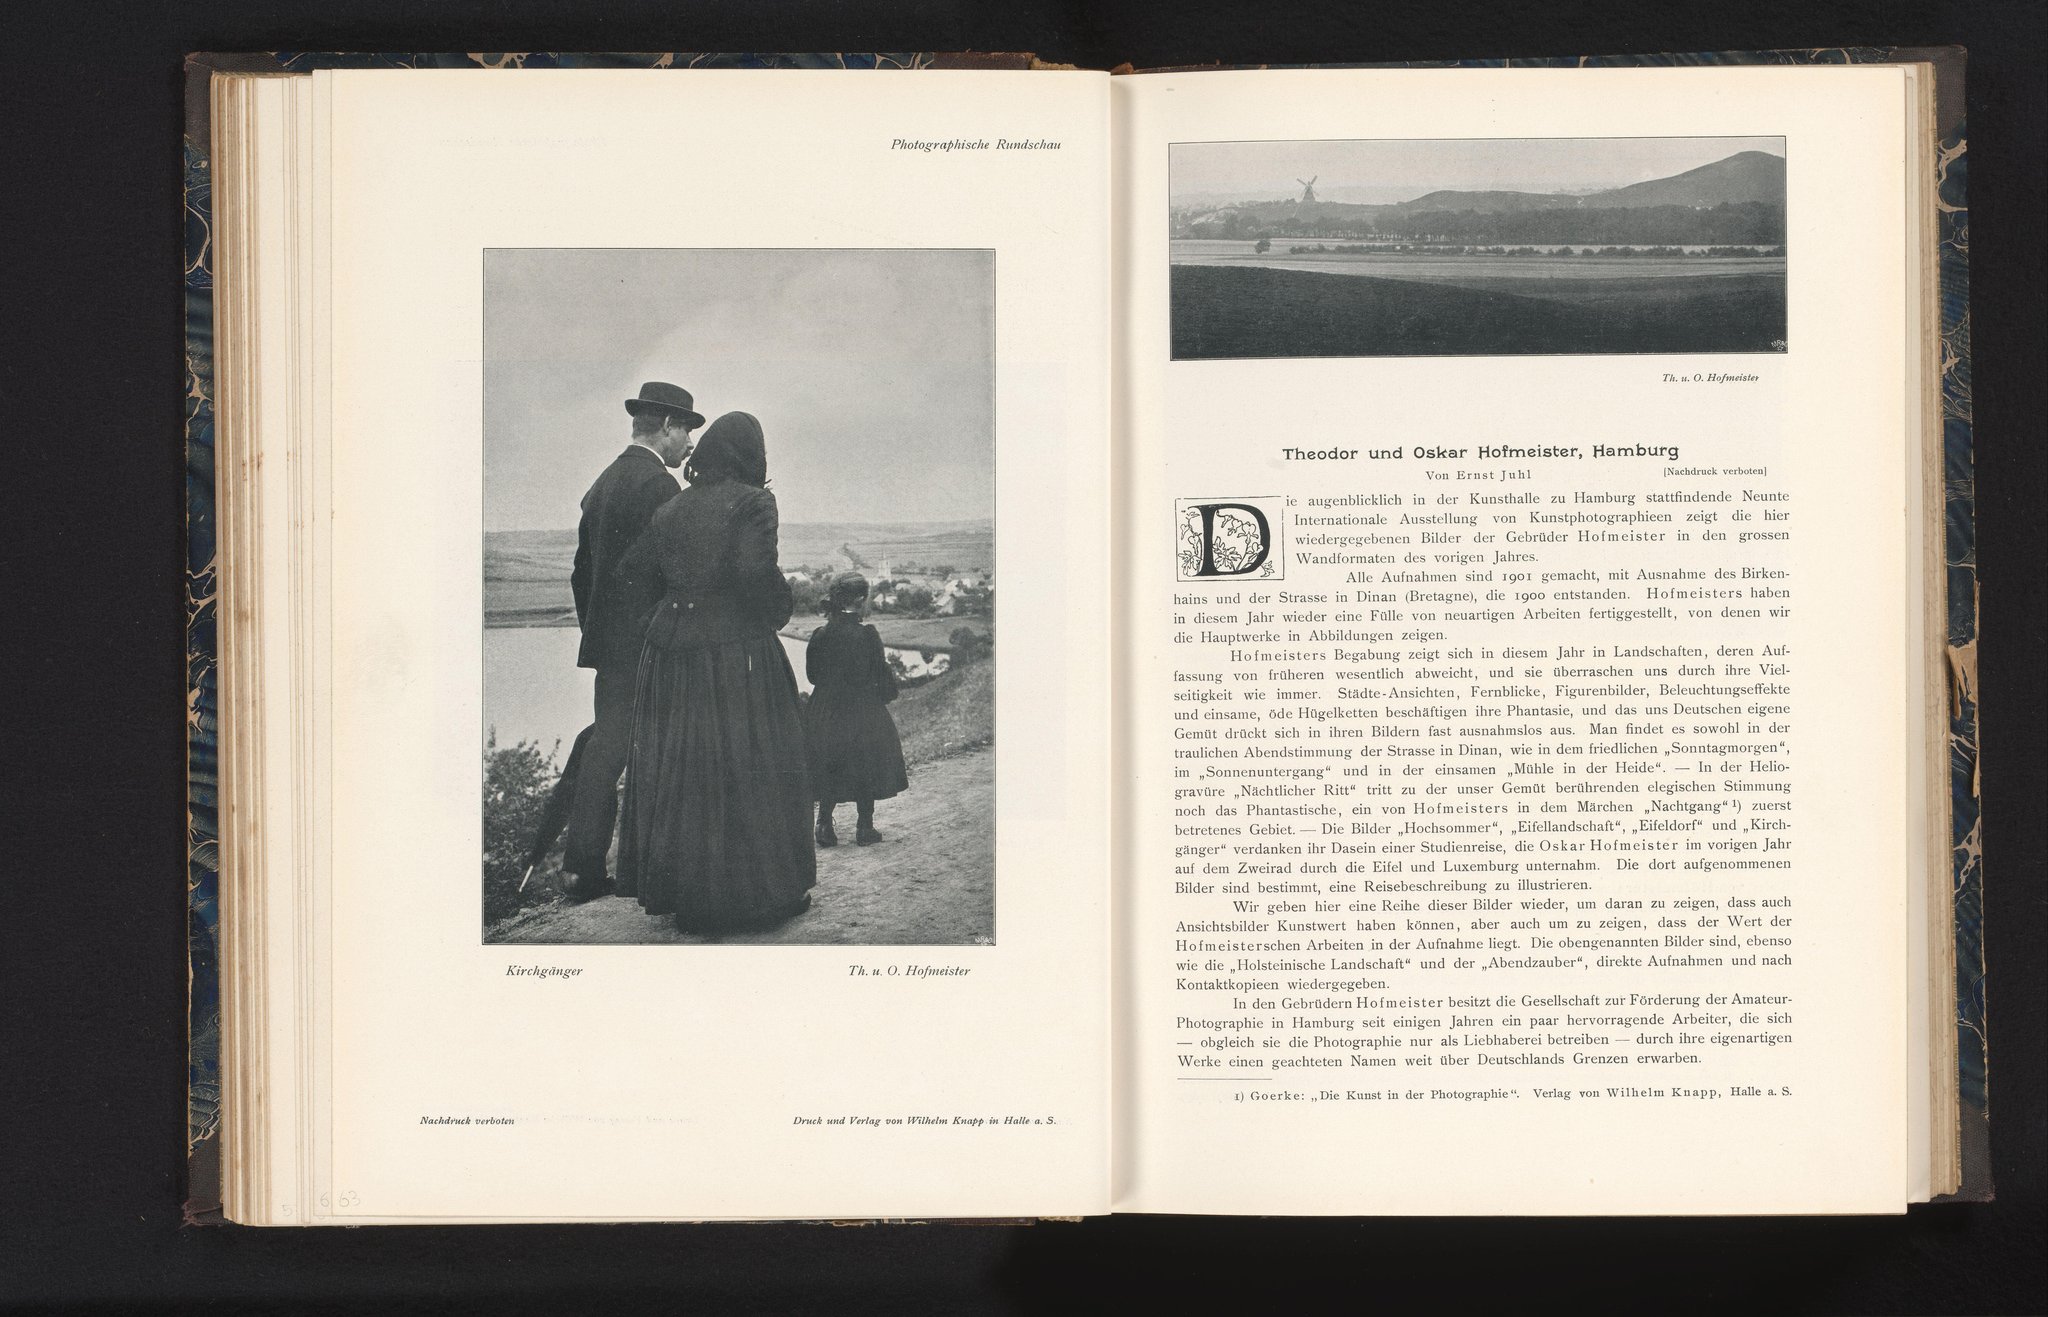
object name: page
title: Gezicht op een landschap met een molen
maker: th. u. o. hofmeister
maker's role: fotograaf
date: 1897-1902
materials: paper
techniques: autotype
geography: berlin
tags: windmill in landscape